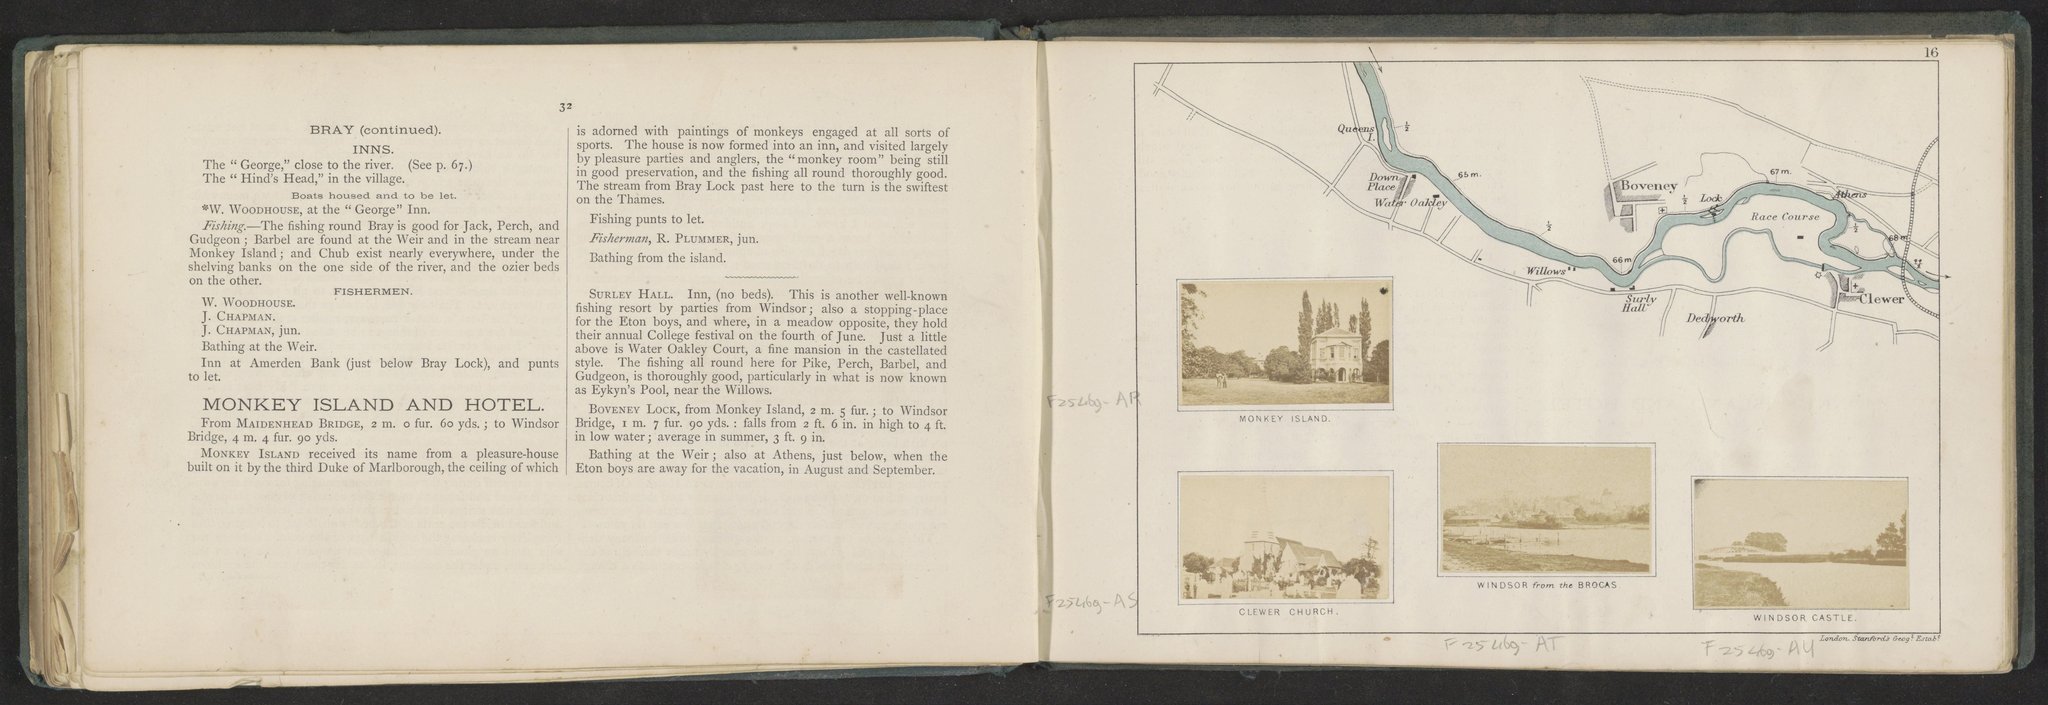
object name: photograph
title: Gezicht op een kerk in Clewer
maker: henry w. taunt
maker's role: fotograaf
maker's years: 1842-1922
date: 1871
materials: photographic support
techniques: albumen print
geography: clewer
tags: church (exterior)